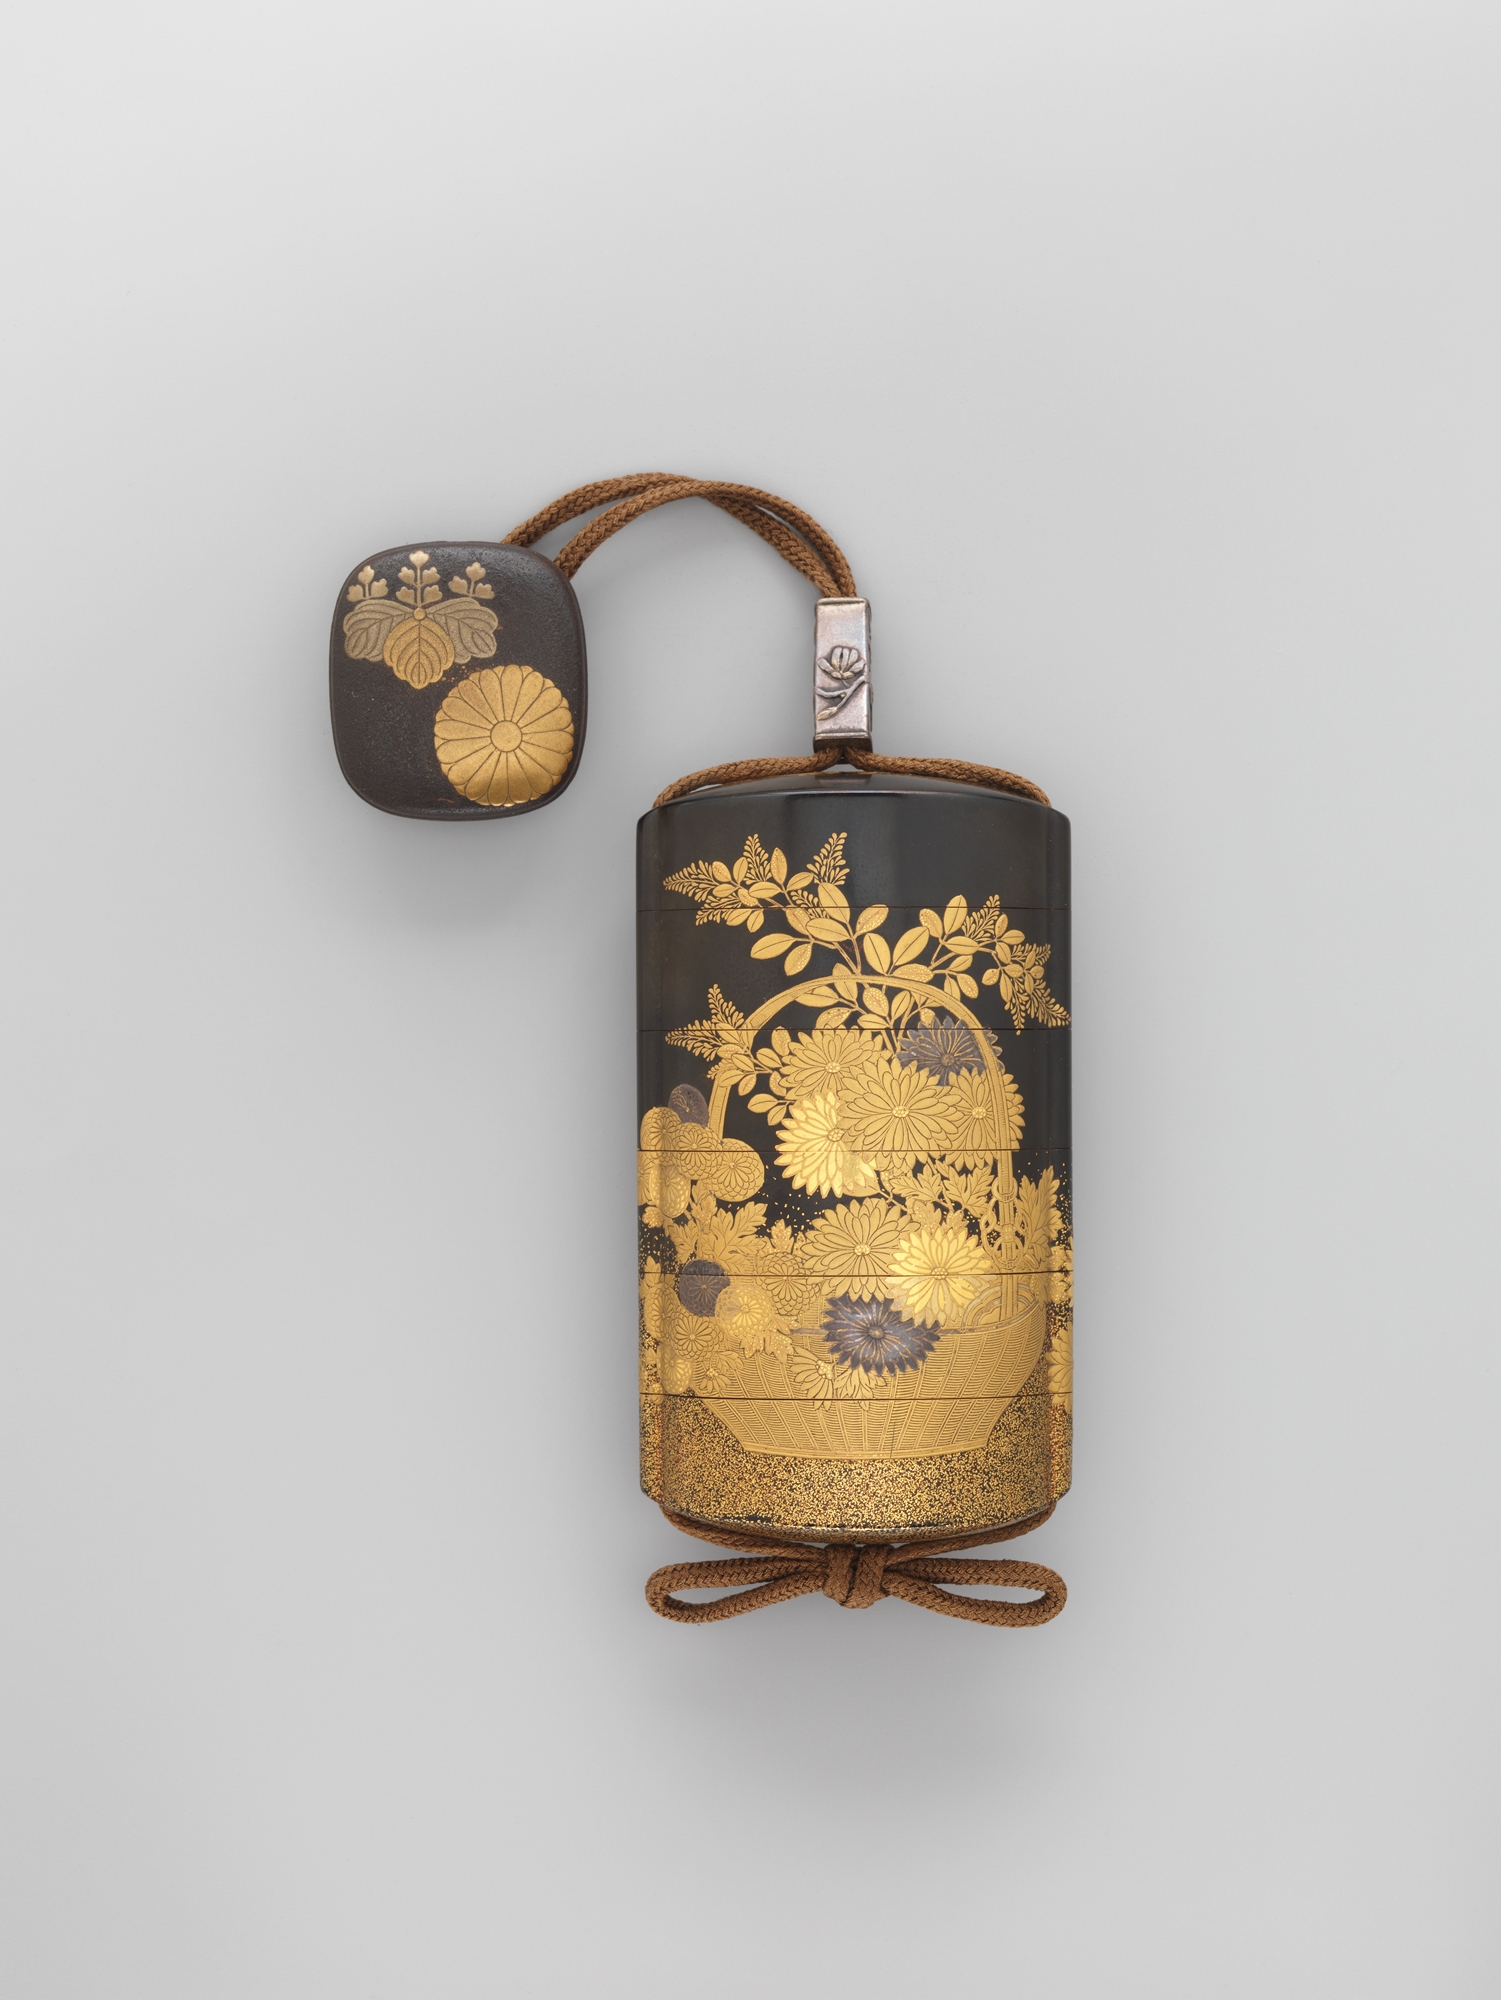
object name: inrō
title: Inrō with Basket of Spring Flowers (obverse); Basket of Autumn Flowers (reverse)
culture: japanese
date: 1767-1833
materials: gold, gold foil, lacquer, silver, wood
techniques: hiramakie, inlay, lacquer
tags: flowers